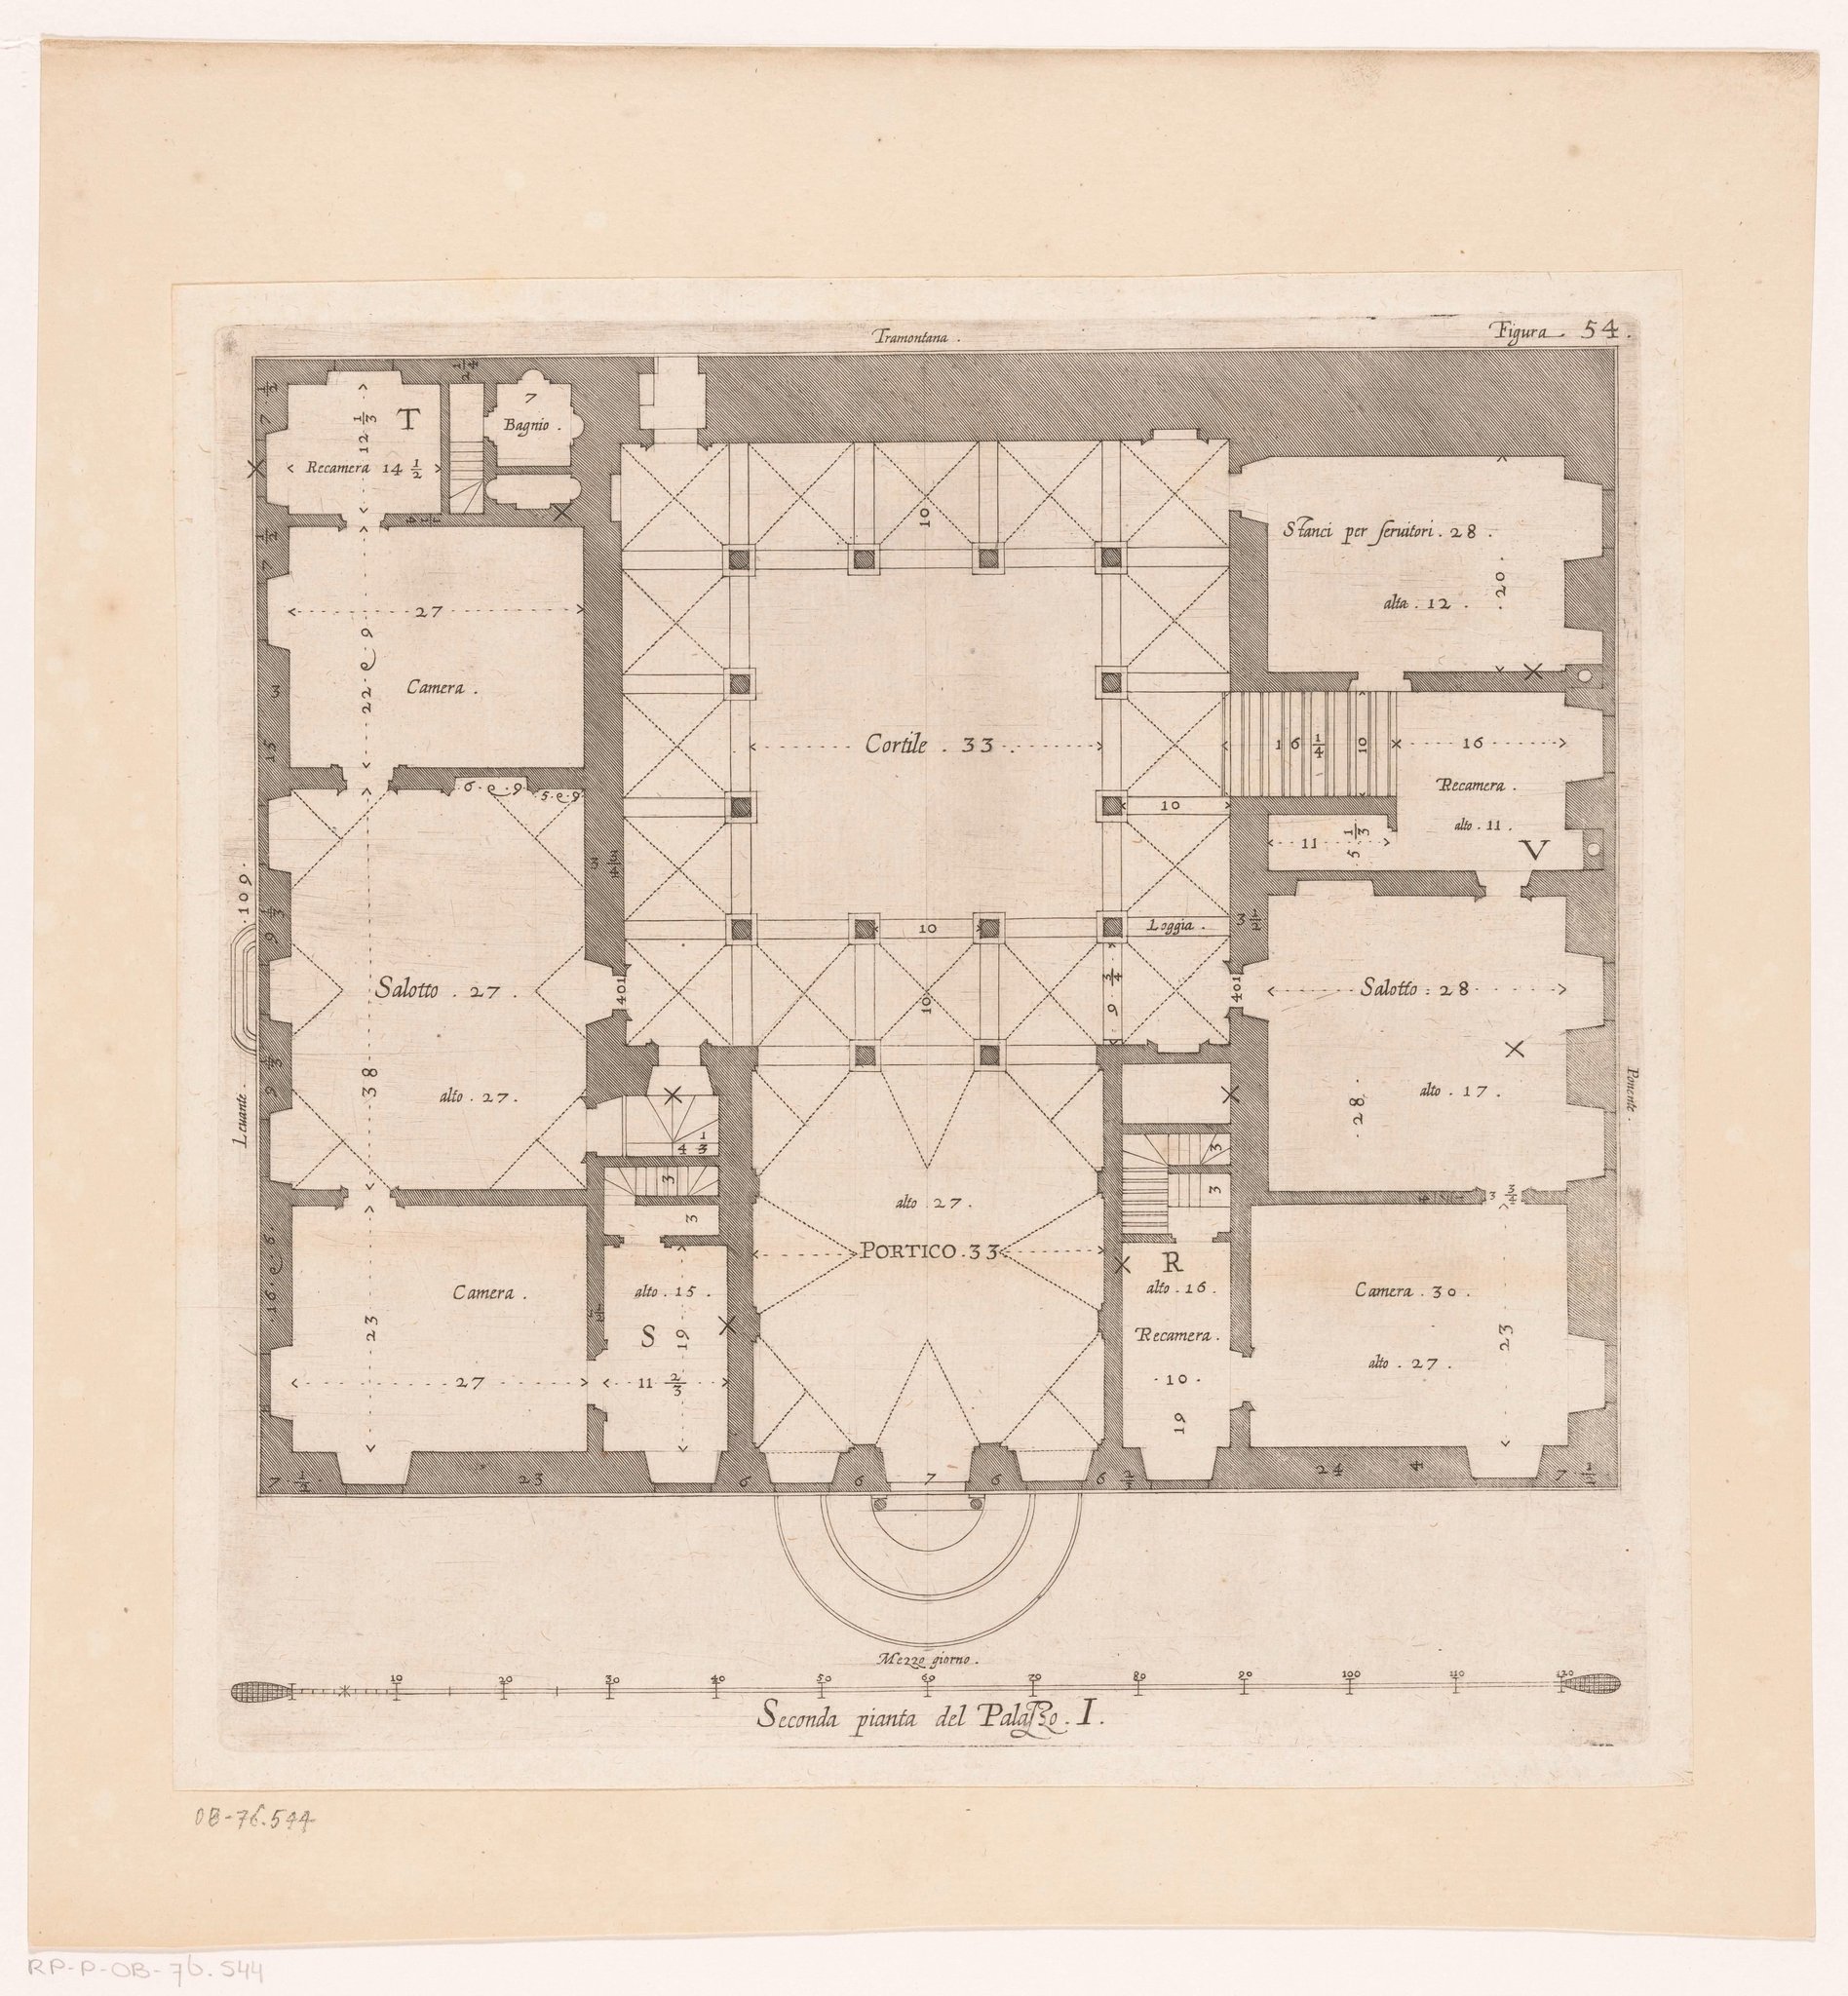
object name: ornament print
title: Plattegrond van de begane grond van het Palazzo Rostan Raggio te Genua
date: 1622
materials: paper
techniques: engraving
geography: antwerp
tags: hôtel, i.e. small palace in city - aa - civic architecture: inside, plan ~ architecture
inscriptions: collector's mark: Lugt 240